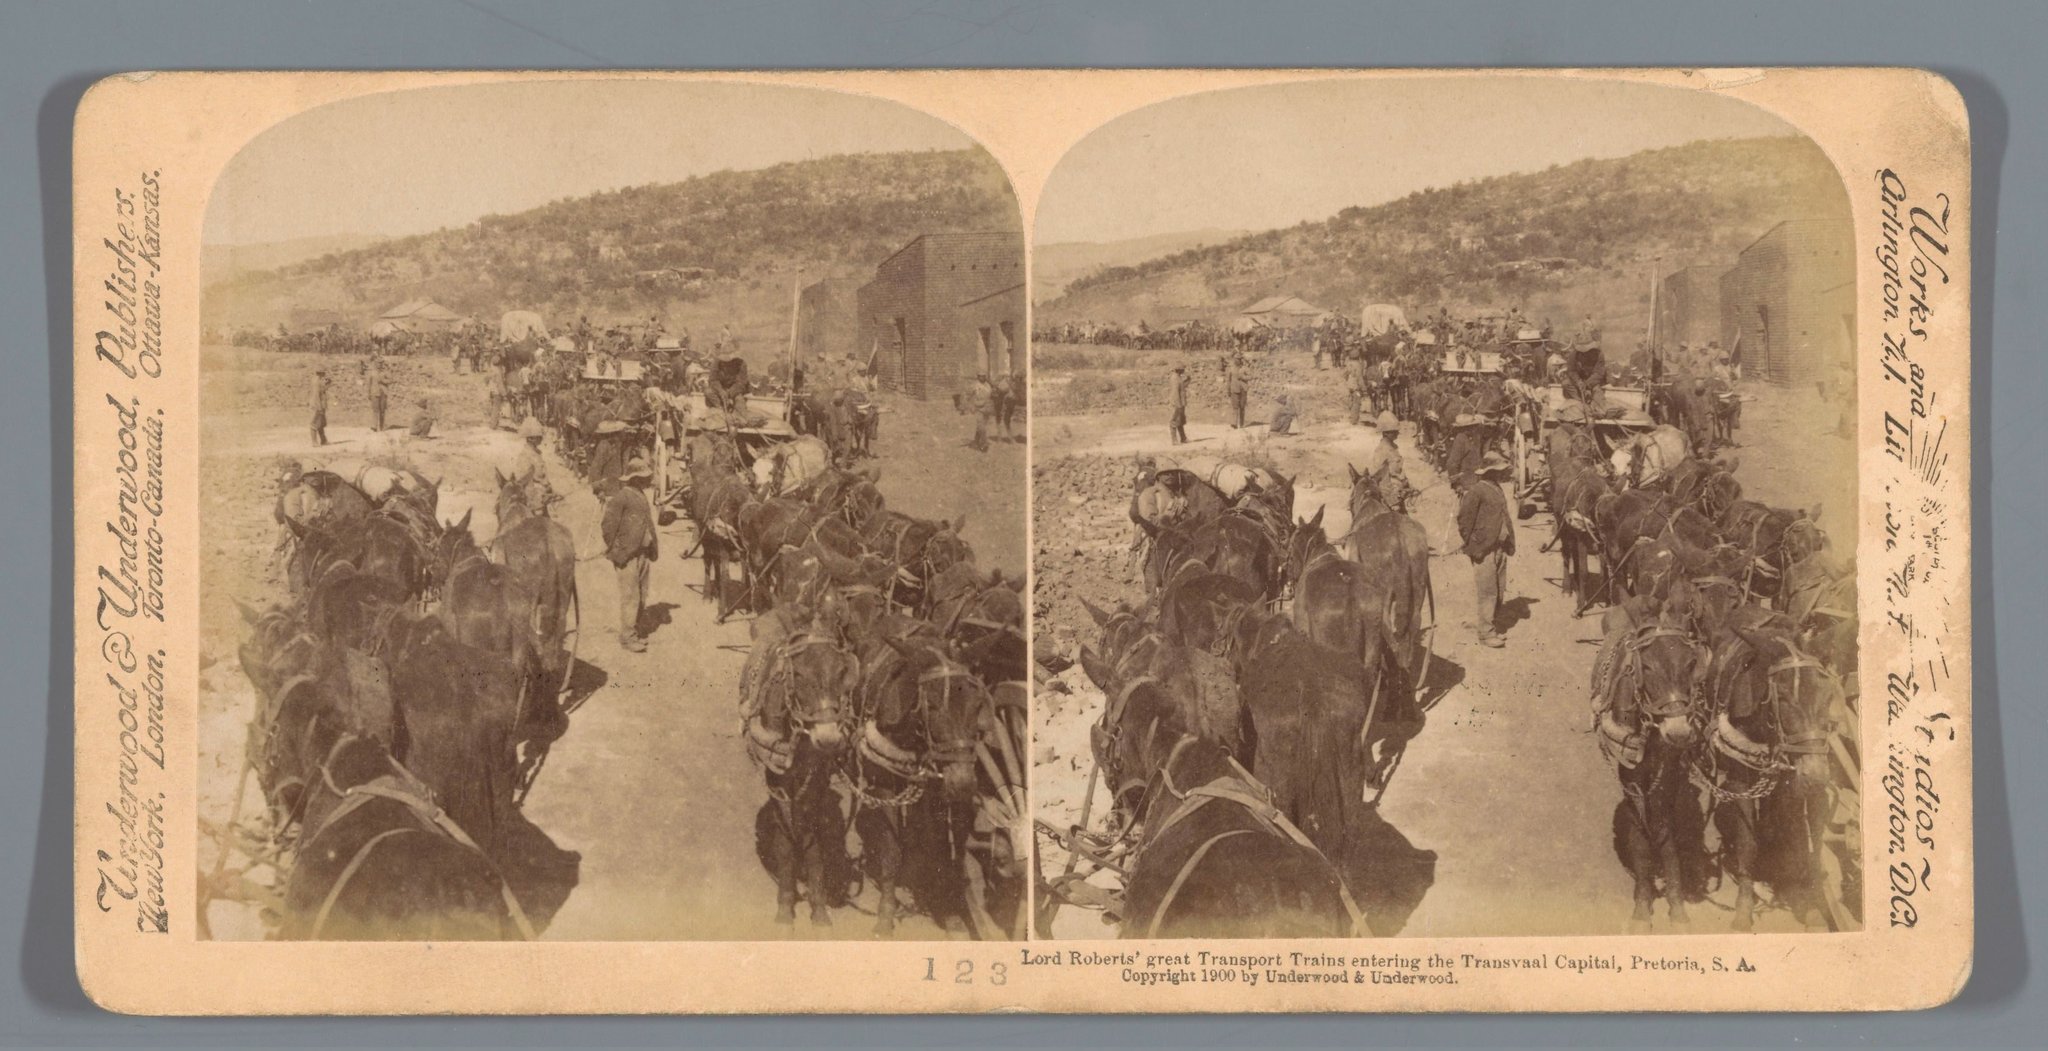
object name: stereograph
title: De troepen van Lord Roberts (Frederick Sleigh Roberts) betreden Pretoria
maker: Anonymous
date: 1900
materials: cardboard, paper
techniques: albumen print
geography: new york city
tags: troop movements, transportation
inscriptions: number: ‘123’, inscription, inscription: ‘Works and Studios ~/ Arlington, N.J. Littleton, N.H. Washington, D.C.’, copyright notice: ‘Copyright 1900 by Underwood & Underwood.’